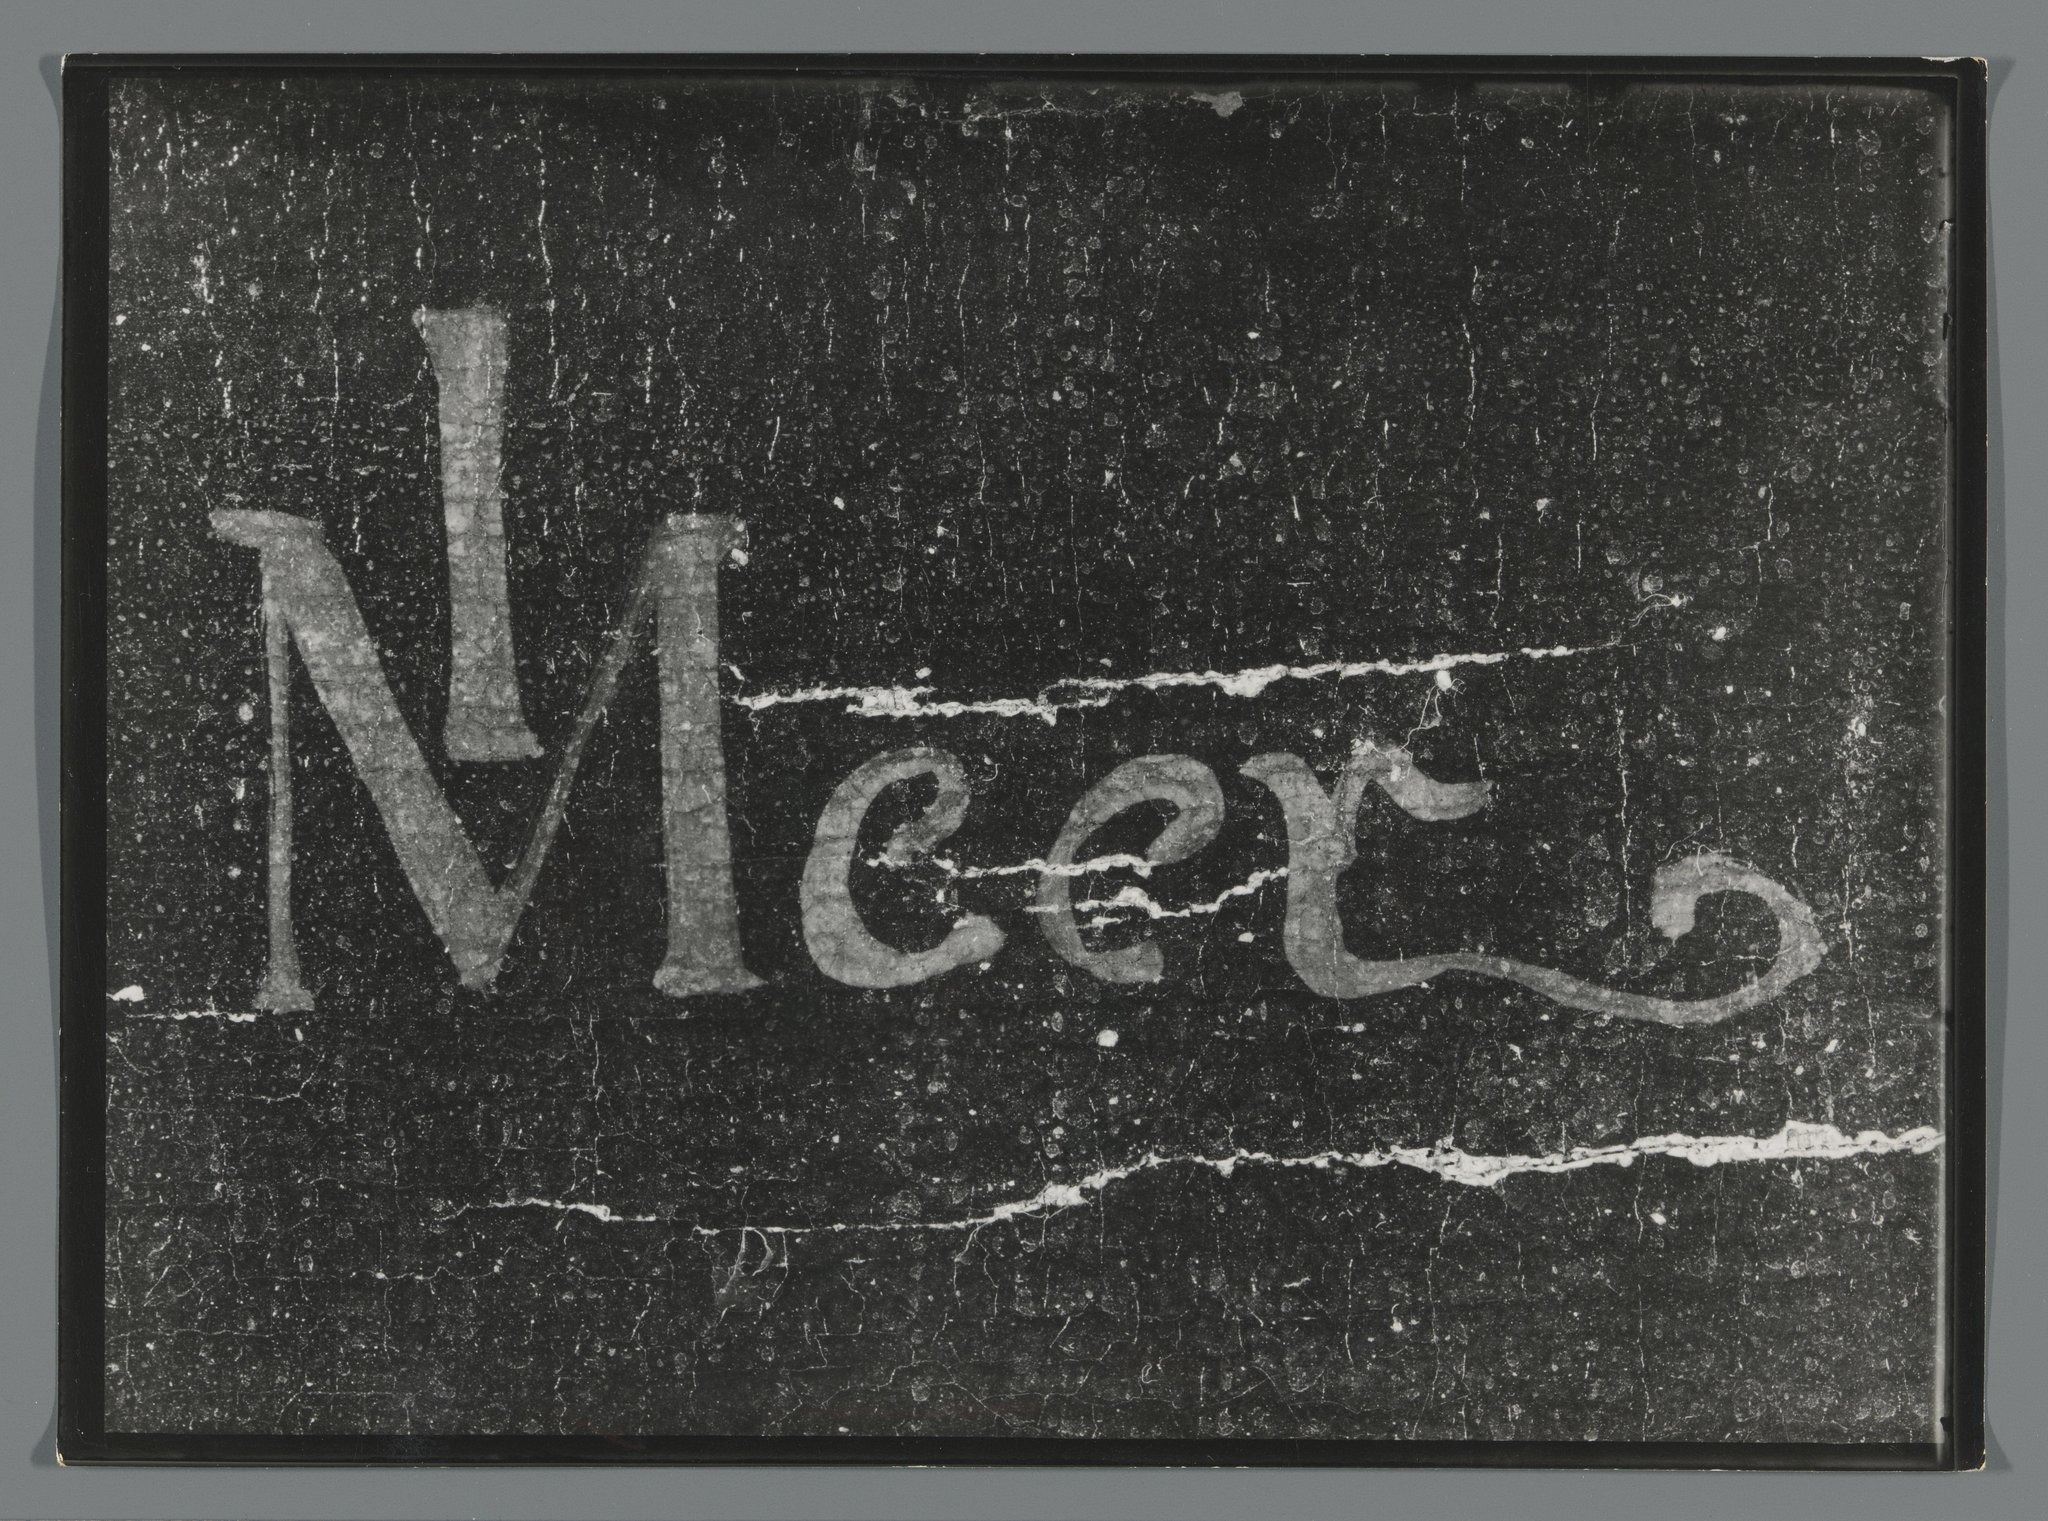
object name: photograph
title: Fotografische reproductie van een (detail) schilderij van Han van Meegeren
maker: nico zomer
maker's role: fotograaf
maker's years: 1910-1988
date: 1908-1948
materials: photographic support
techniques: gelatin silver print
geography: amsterdam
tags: picture, painting